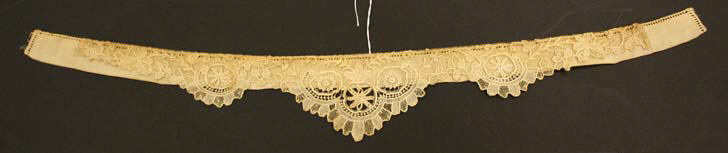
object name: neckcloth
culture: american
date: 1864-1867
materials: cotton